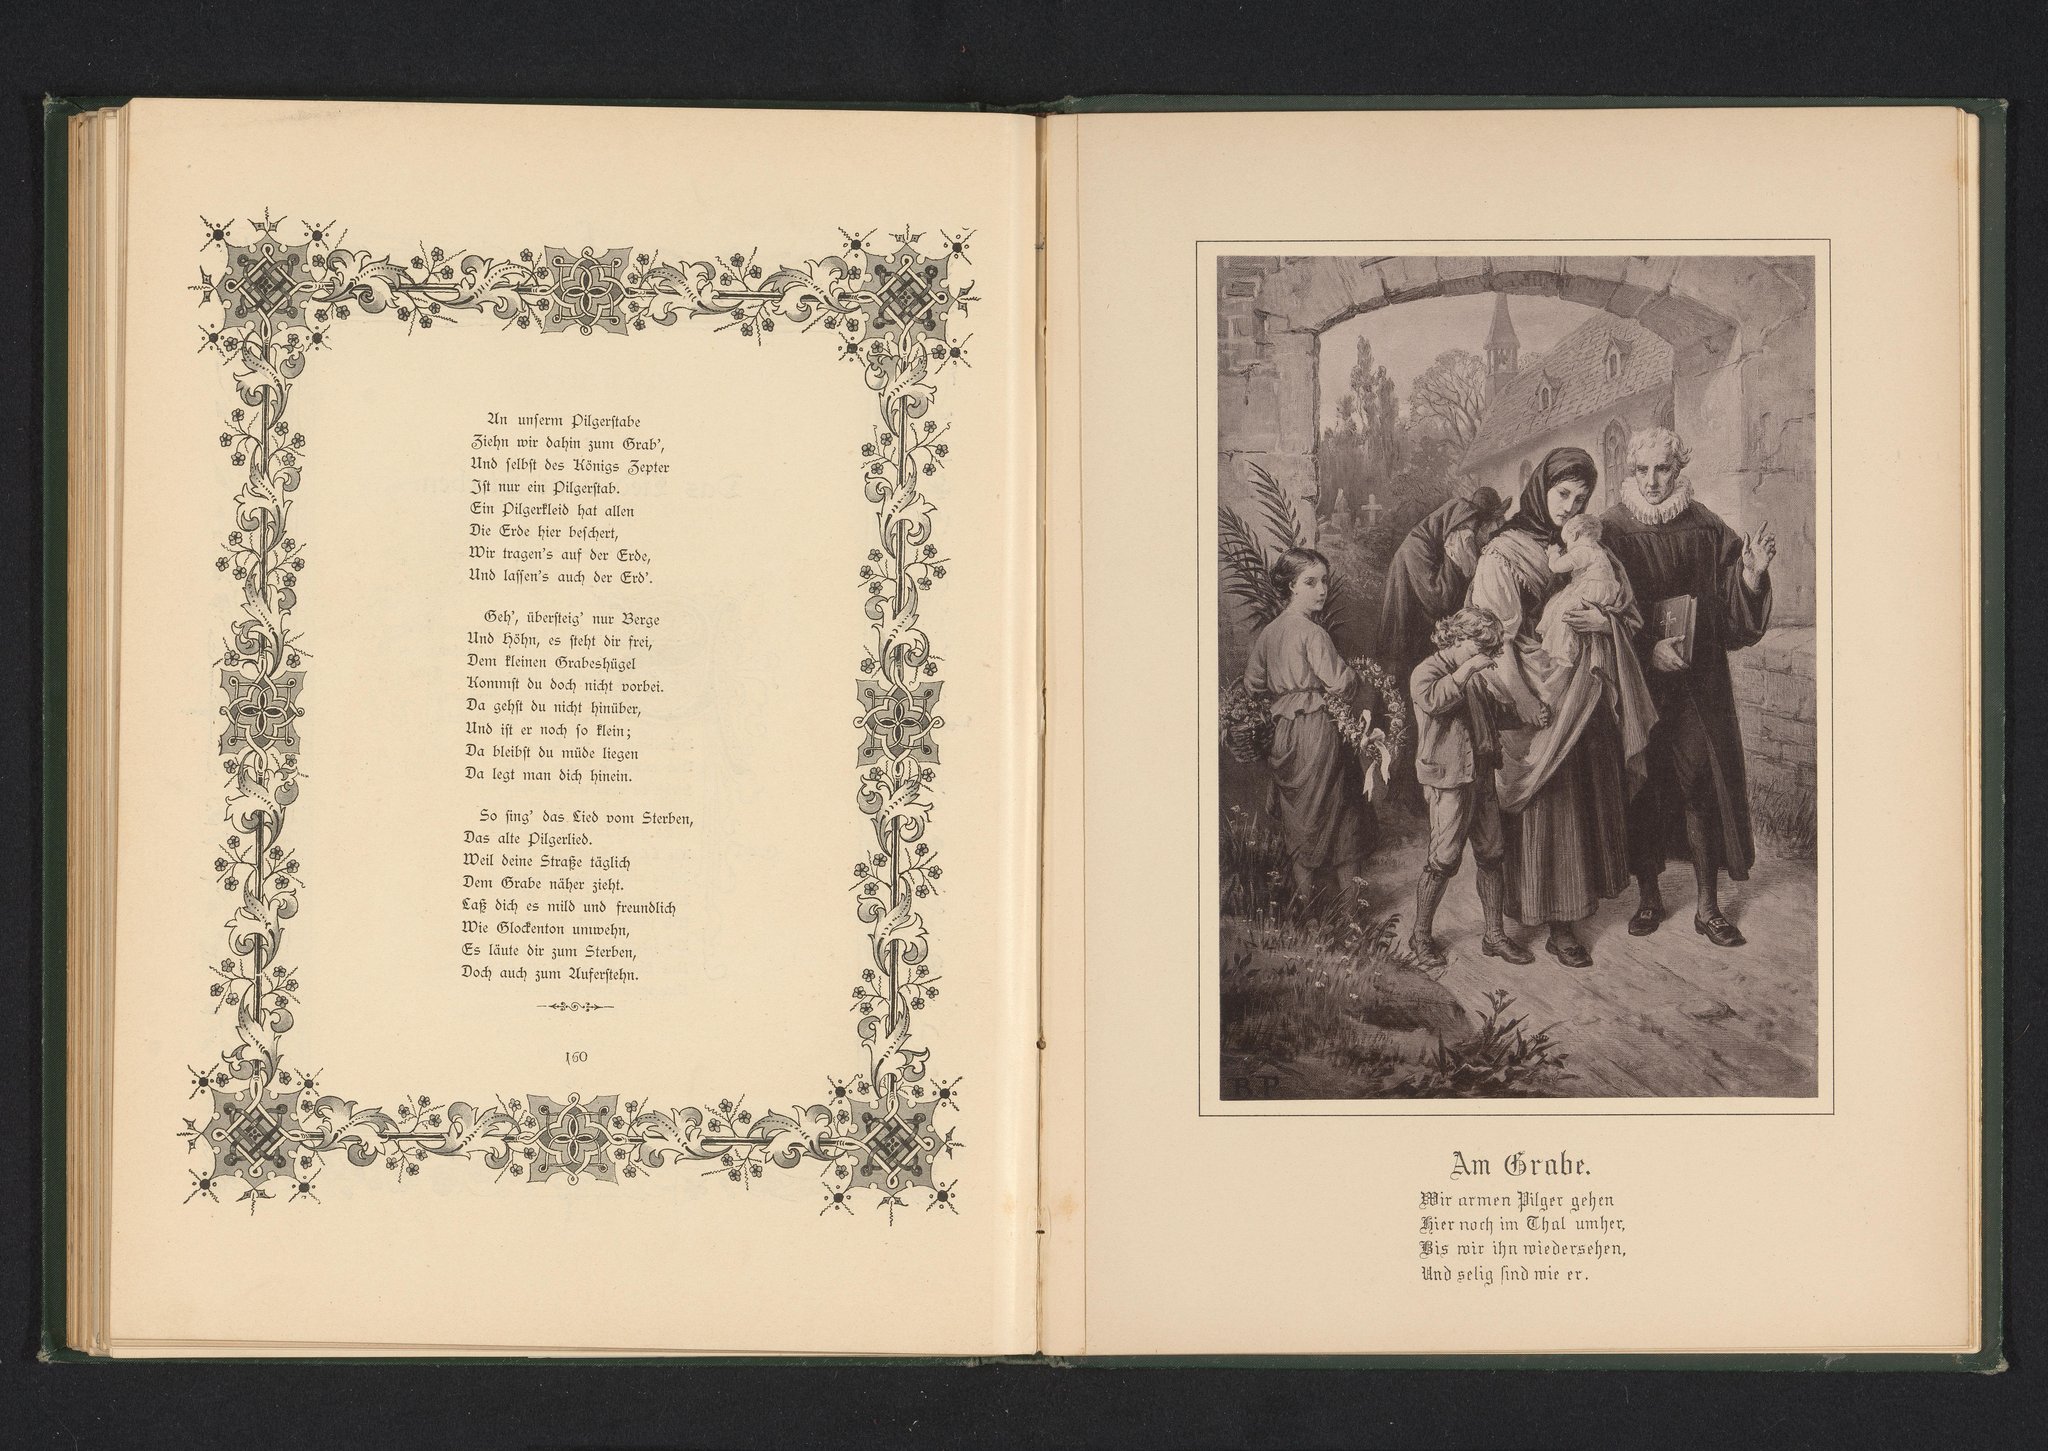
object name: reproduction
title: Fotoreproductie van een schilderij van een familie en een geestelijke bij een begrafenis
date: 1874-1884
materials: paper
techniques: photograph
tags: cortege, funeral procession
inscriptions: inscription: ‘Wir armen Pilger gehen hier noch im Thal umher, Bis mir ihn wiedersehen, Und selig find wie er.’